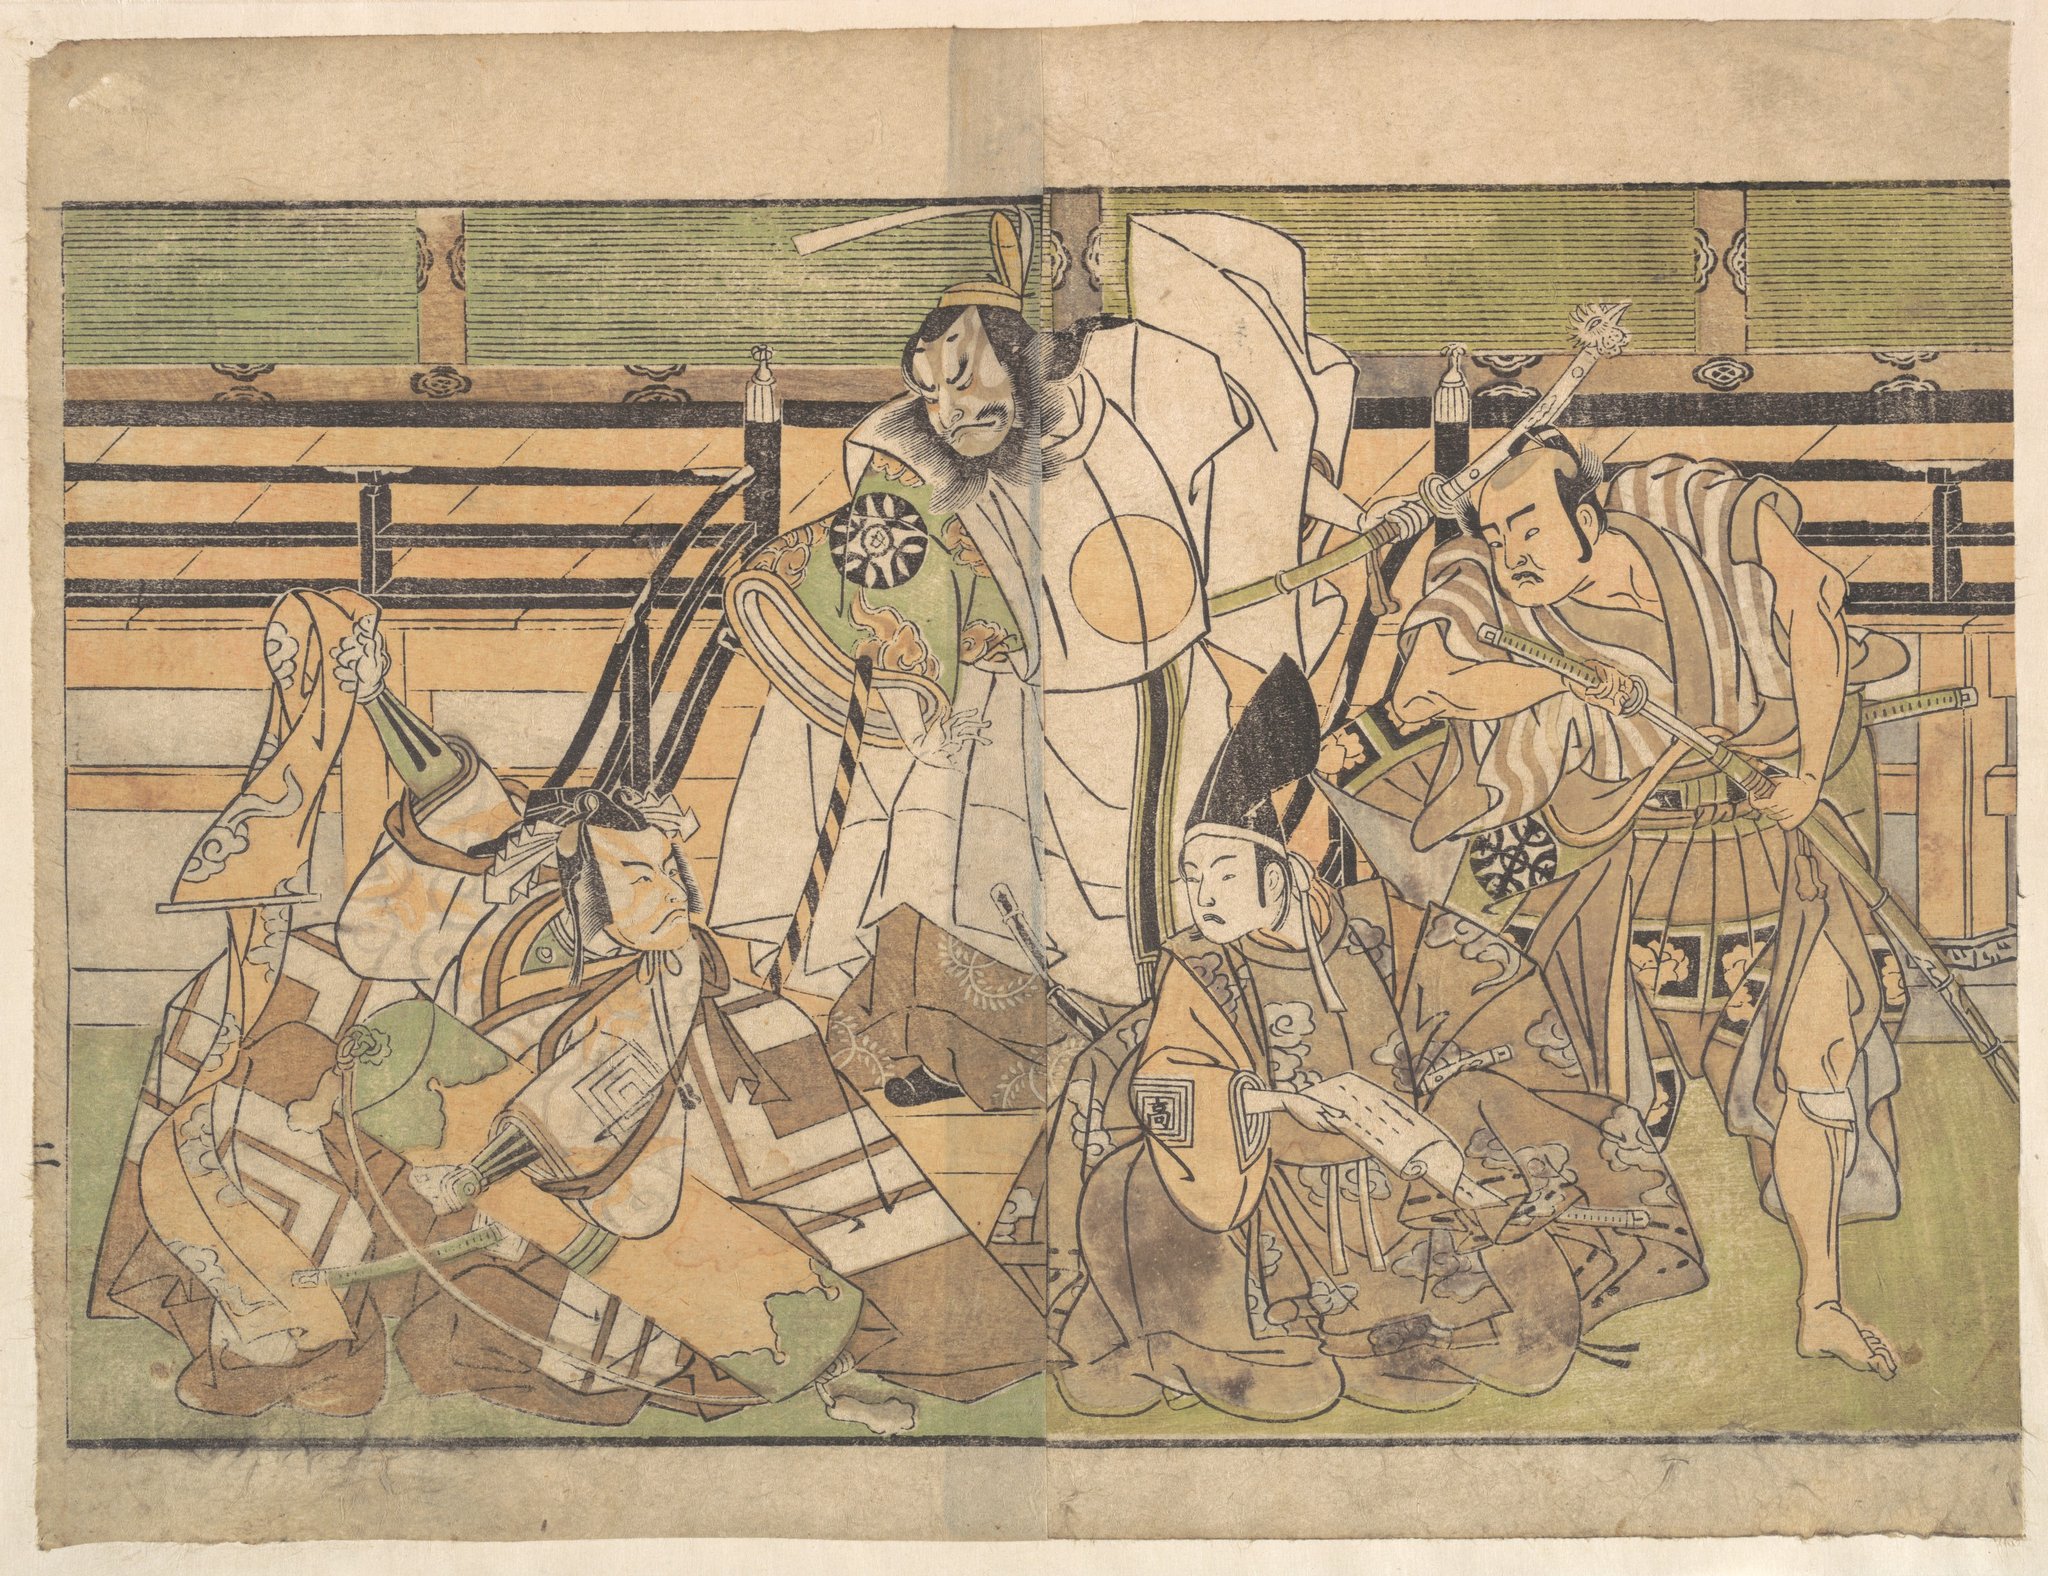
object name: woodblock print nishiki e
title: Four Actors in Unidentified Roles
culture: japanese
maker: katsukawa shunshō 勝川春章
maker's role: artist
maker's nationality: japanese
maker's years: 1726-1792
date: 1726-1792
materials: ink, paper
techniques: nishiki e, woodblock print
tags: swords,men,actors